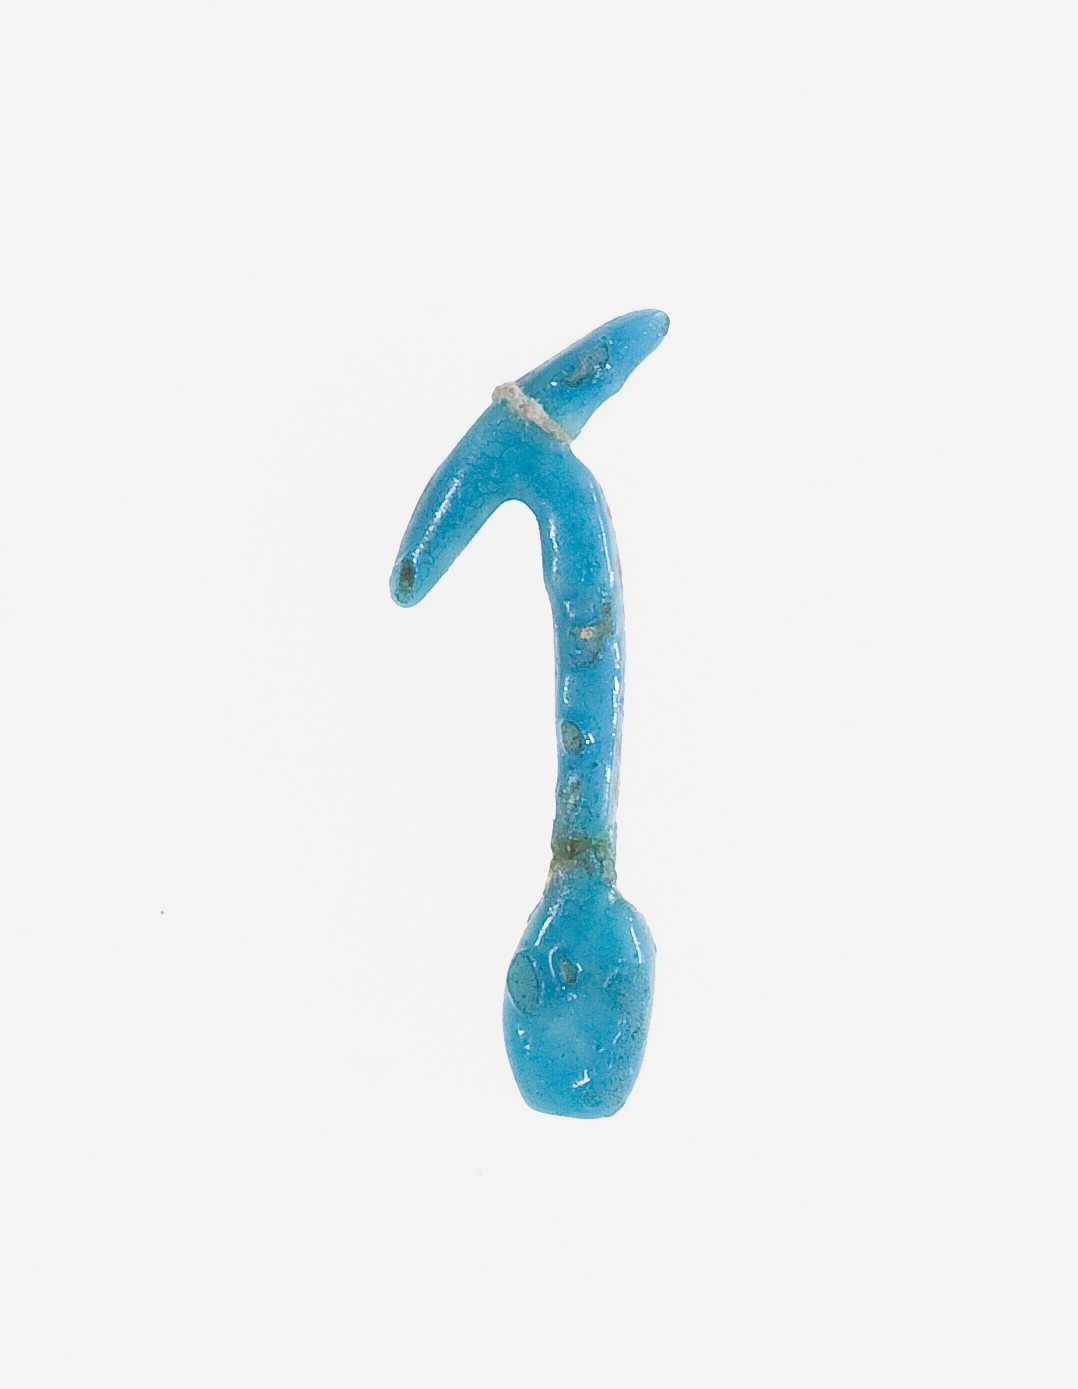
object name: amulet, wa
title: Was Amulet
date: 1390-1352 BCE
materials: faience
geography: egypt